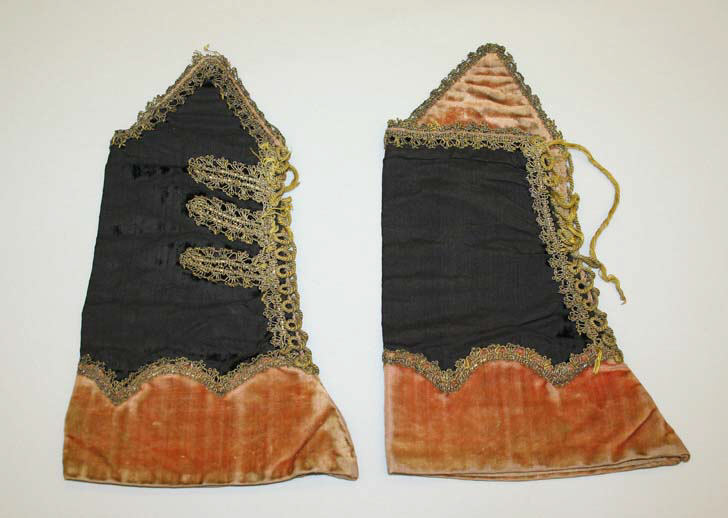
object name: mitt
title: Mitts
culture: italian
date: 1750-1775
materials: metal, silk